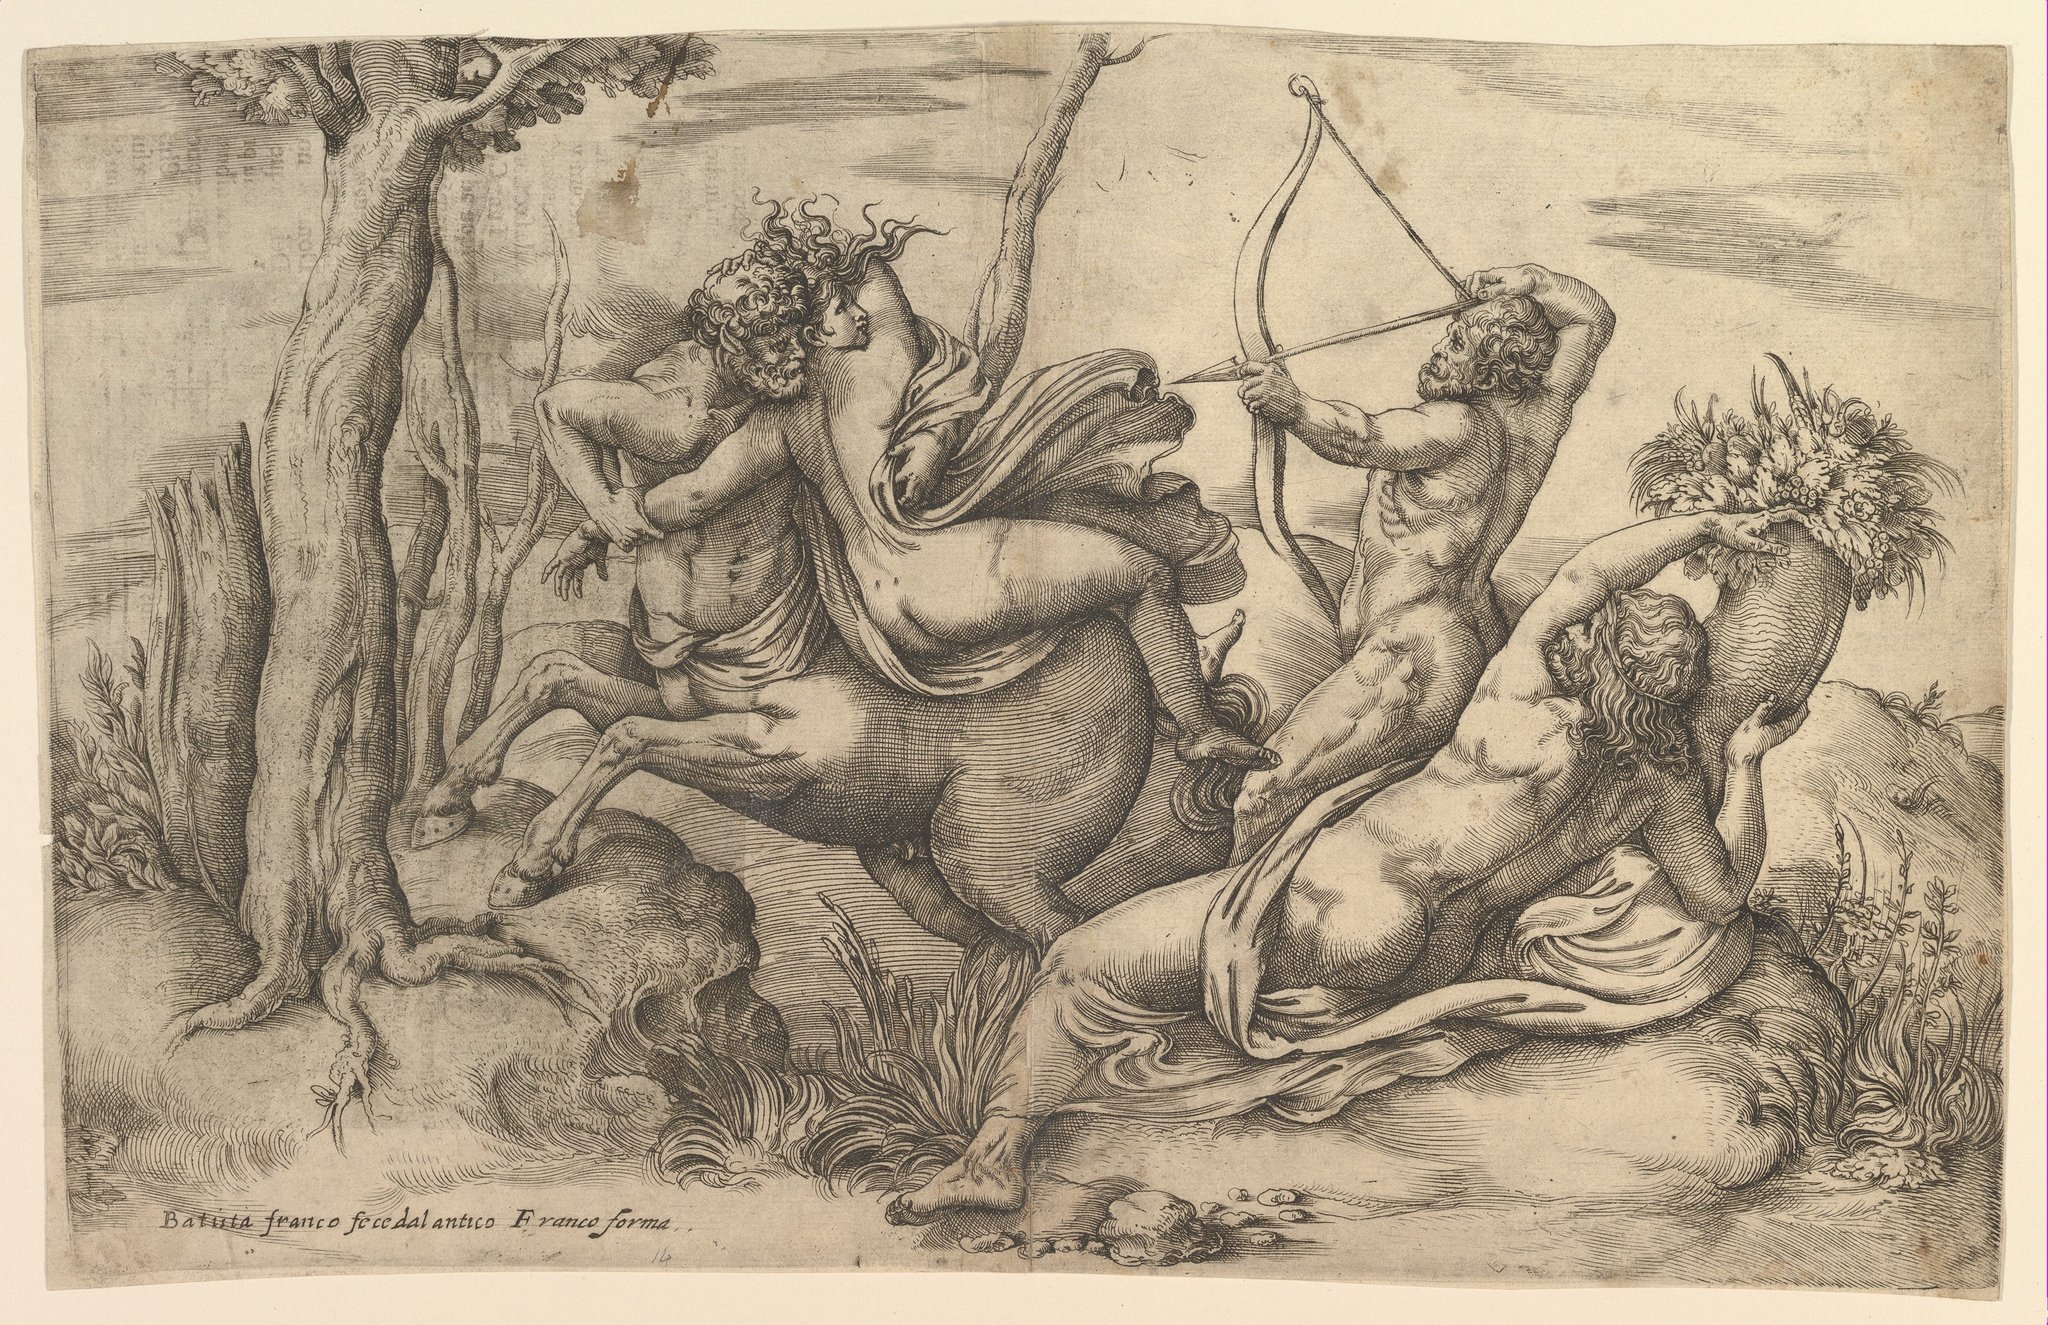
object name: print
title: The Abduction of Dejanira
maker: battista franco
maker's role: artist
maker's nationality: italian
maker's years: 1510-1561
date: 1501-1600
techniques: engraving, etching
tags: bow and arrow,male nudes,female nudes,centaurs,trees